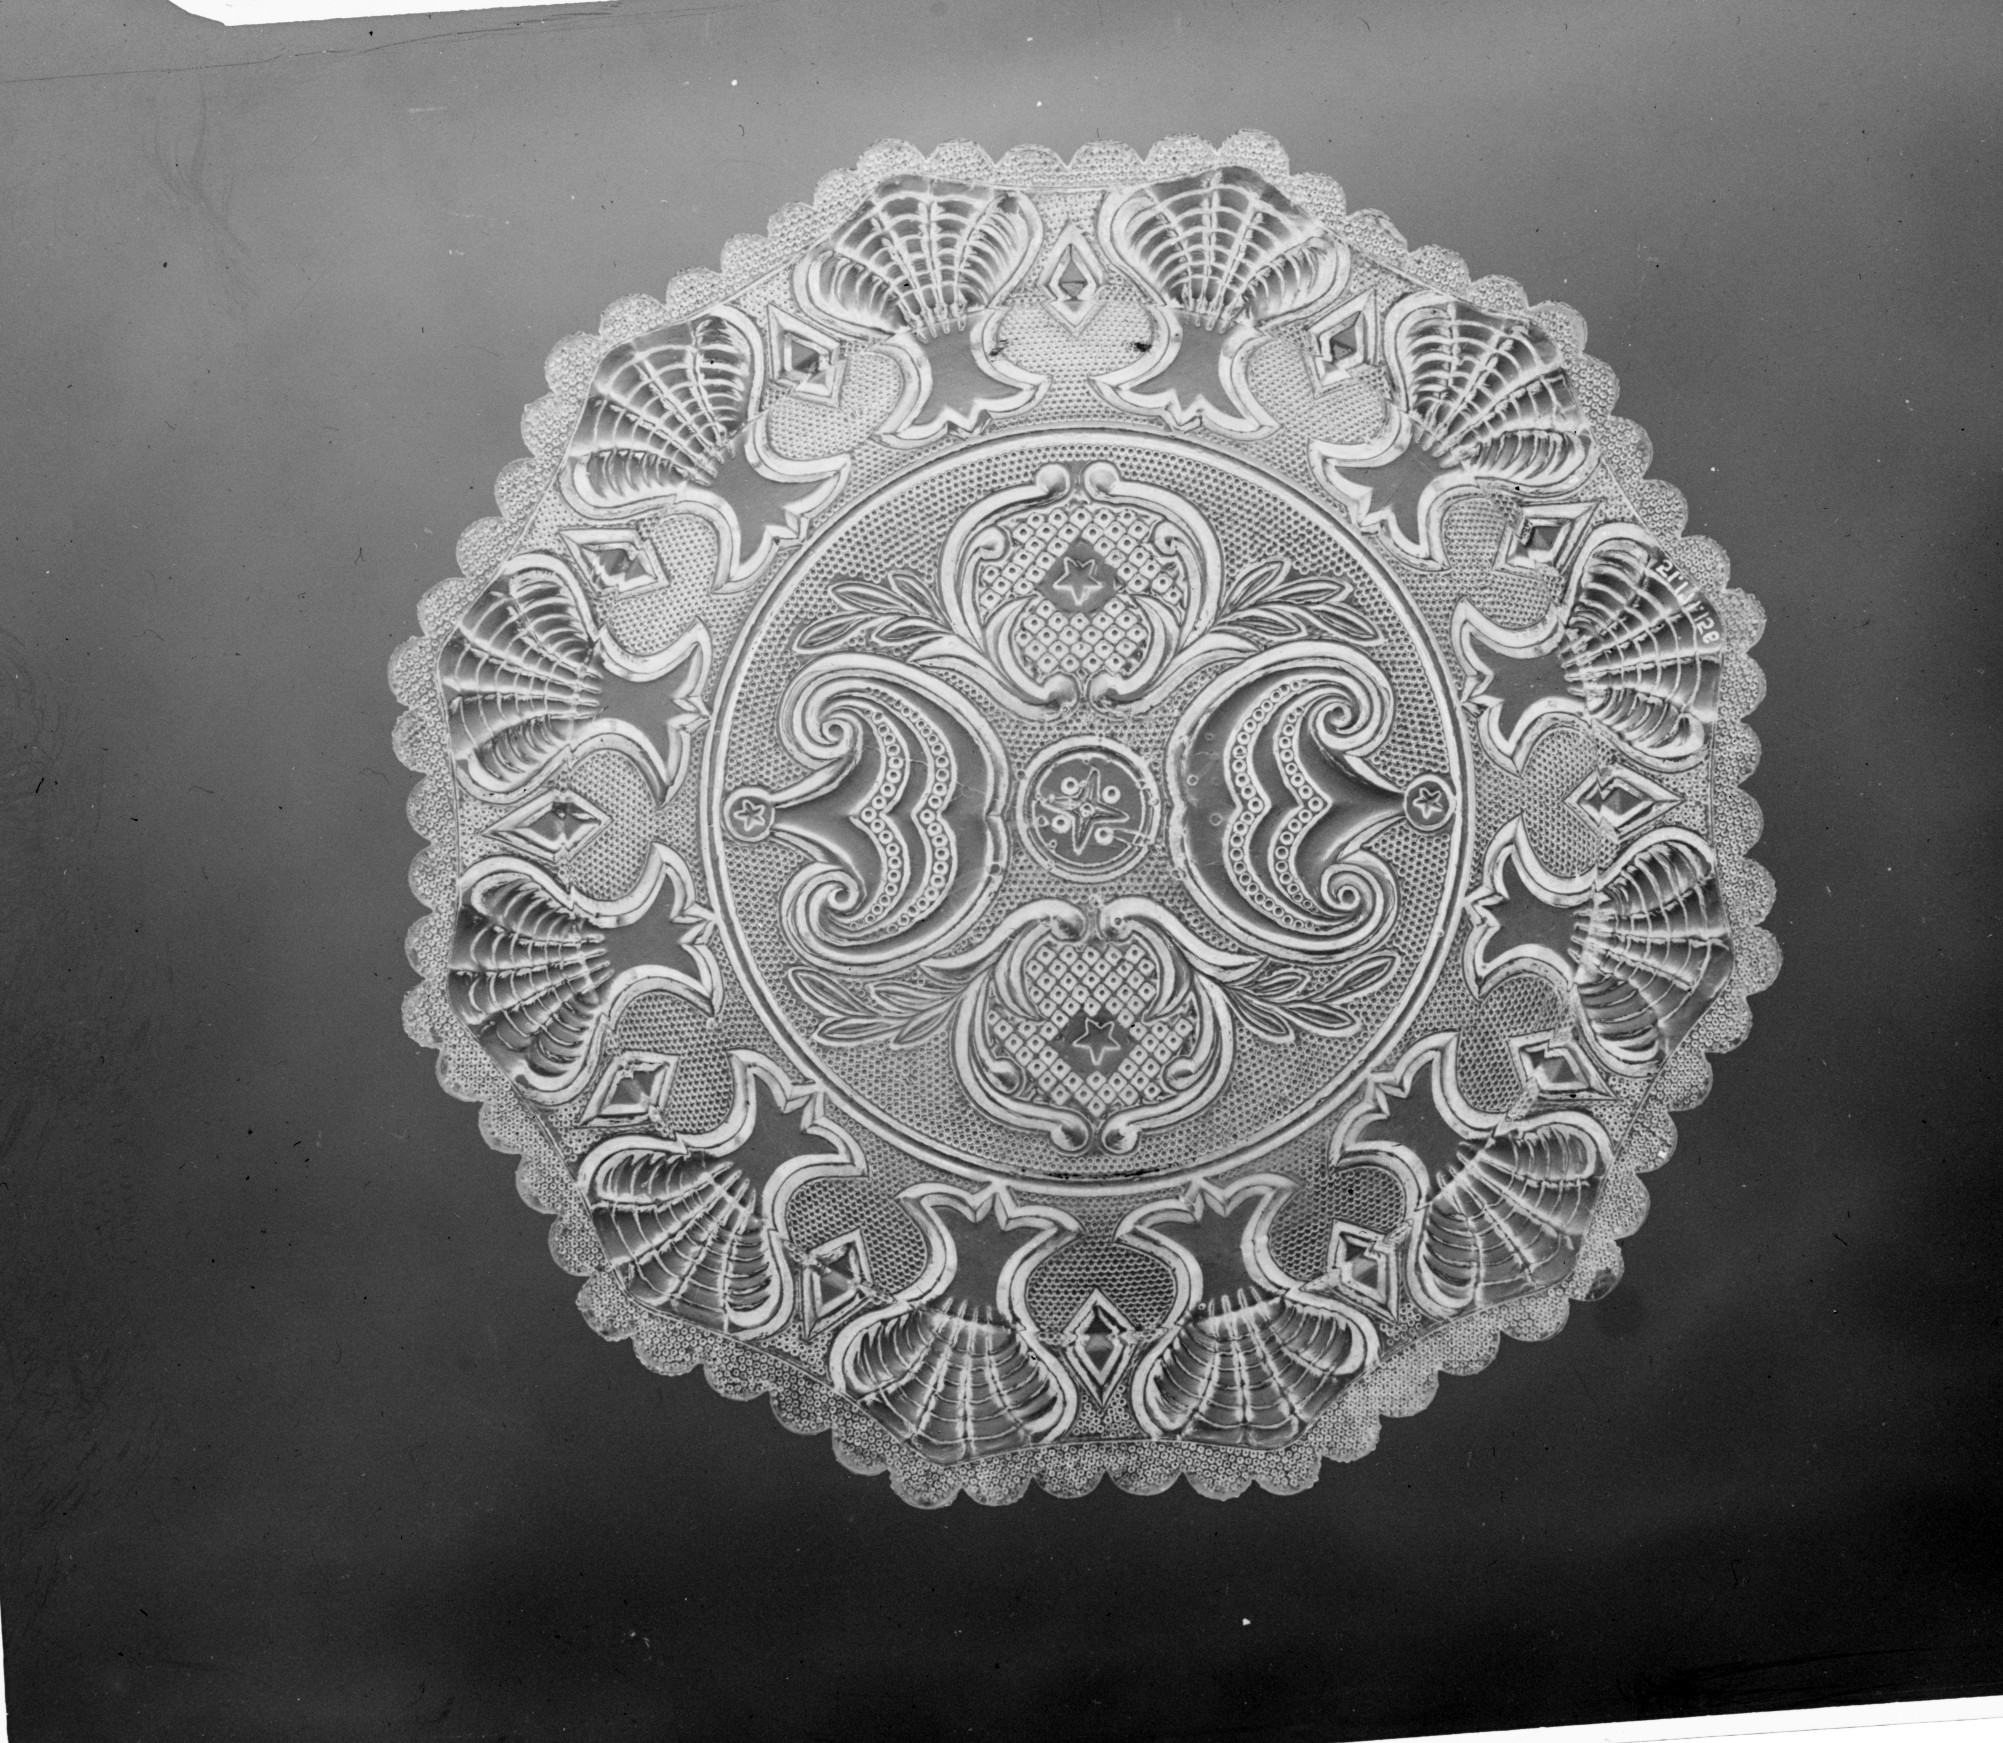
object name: plate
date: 1800-1900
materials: glass